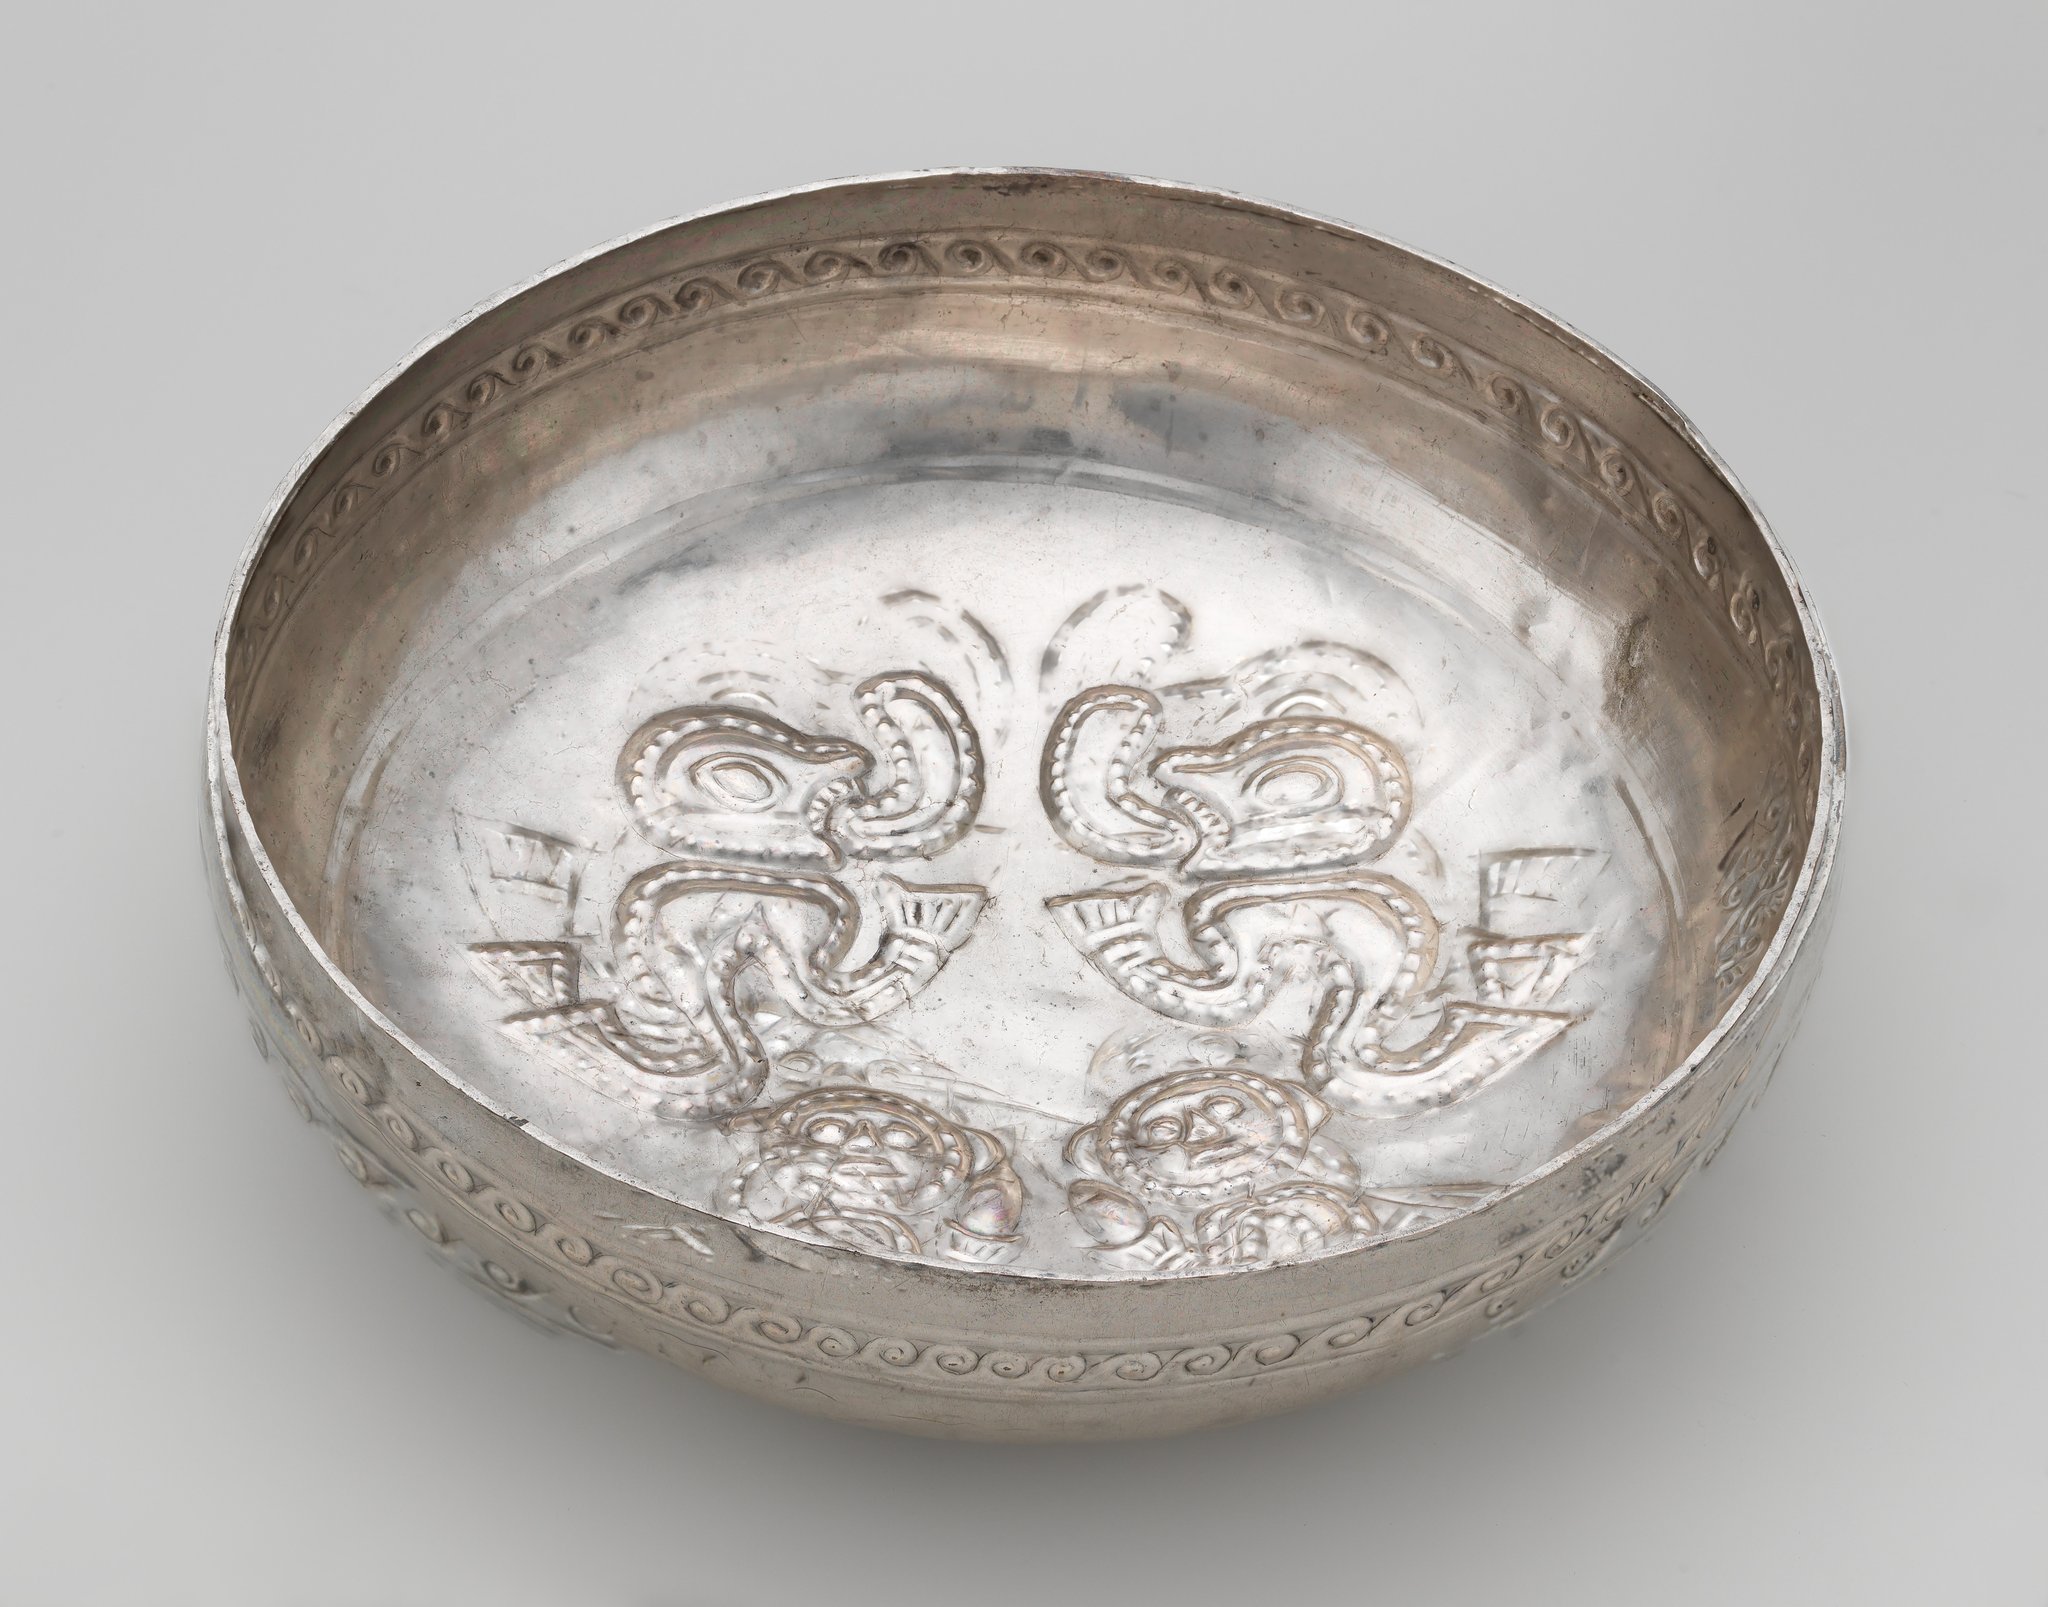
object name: bowl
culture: chimú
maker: chimú artist(s)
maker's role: artist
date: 1000-1470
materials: silver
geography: peru